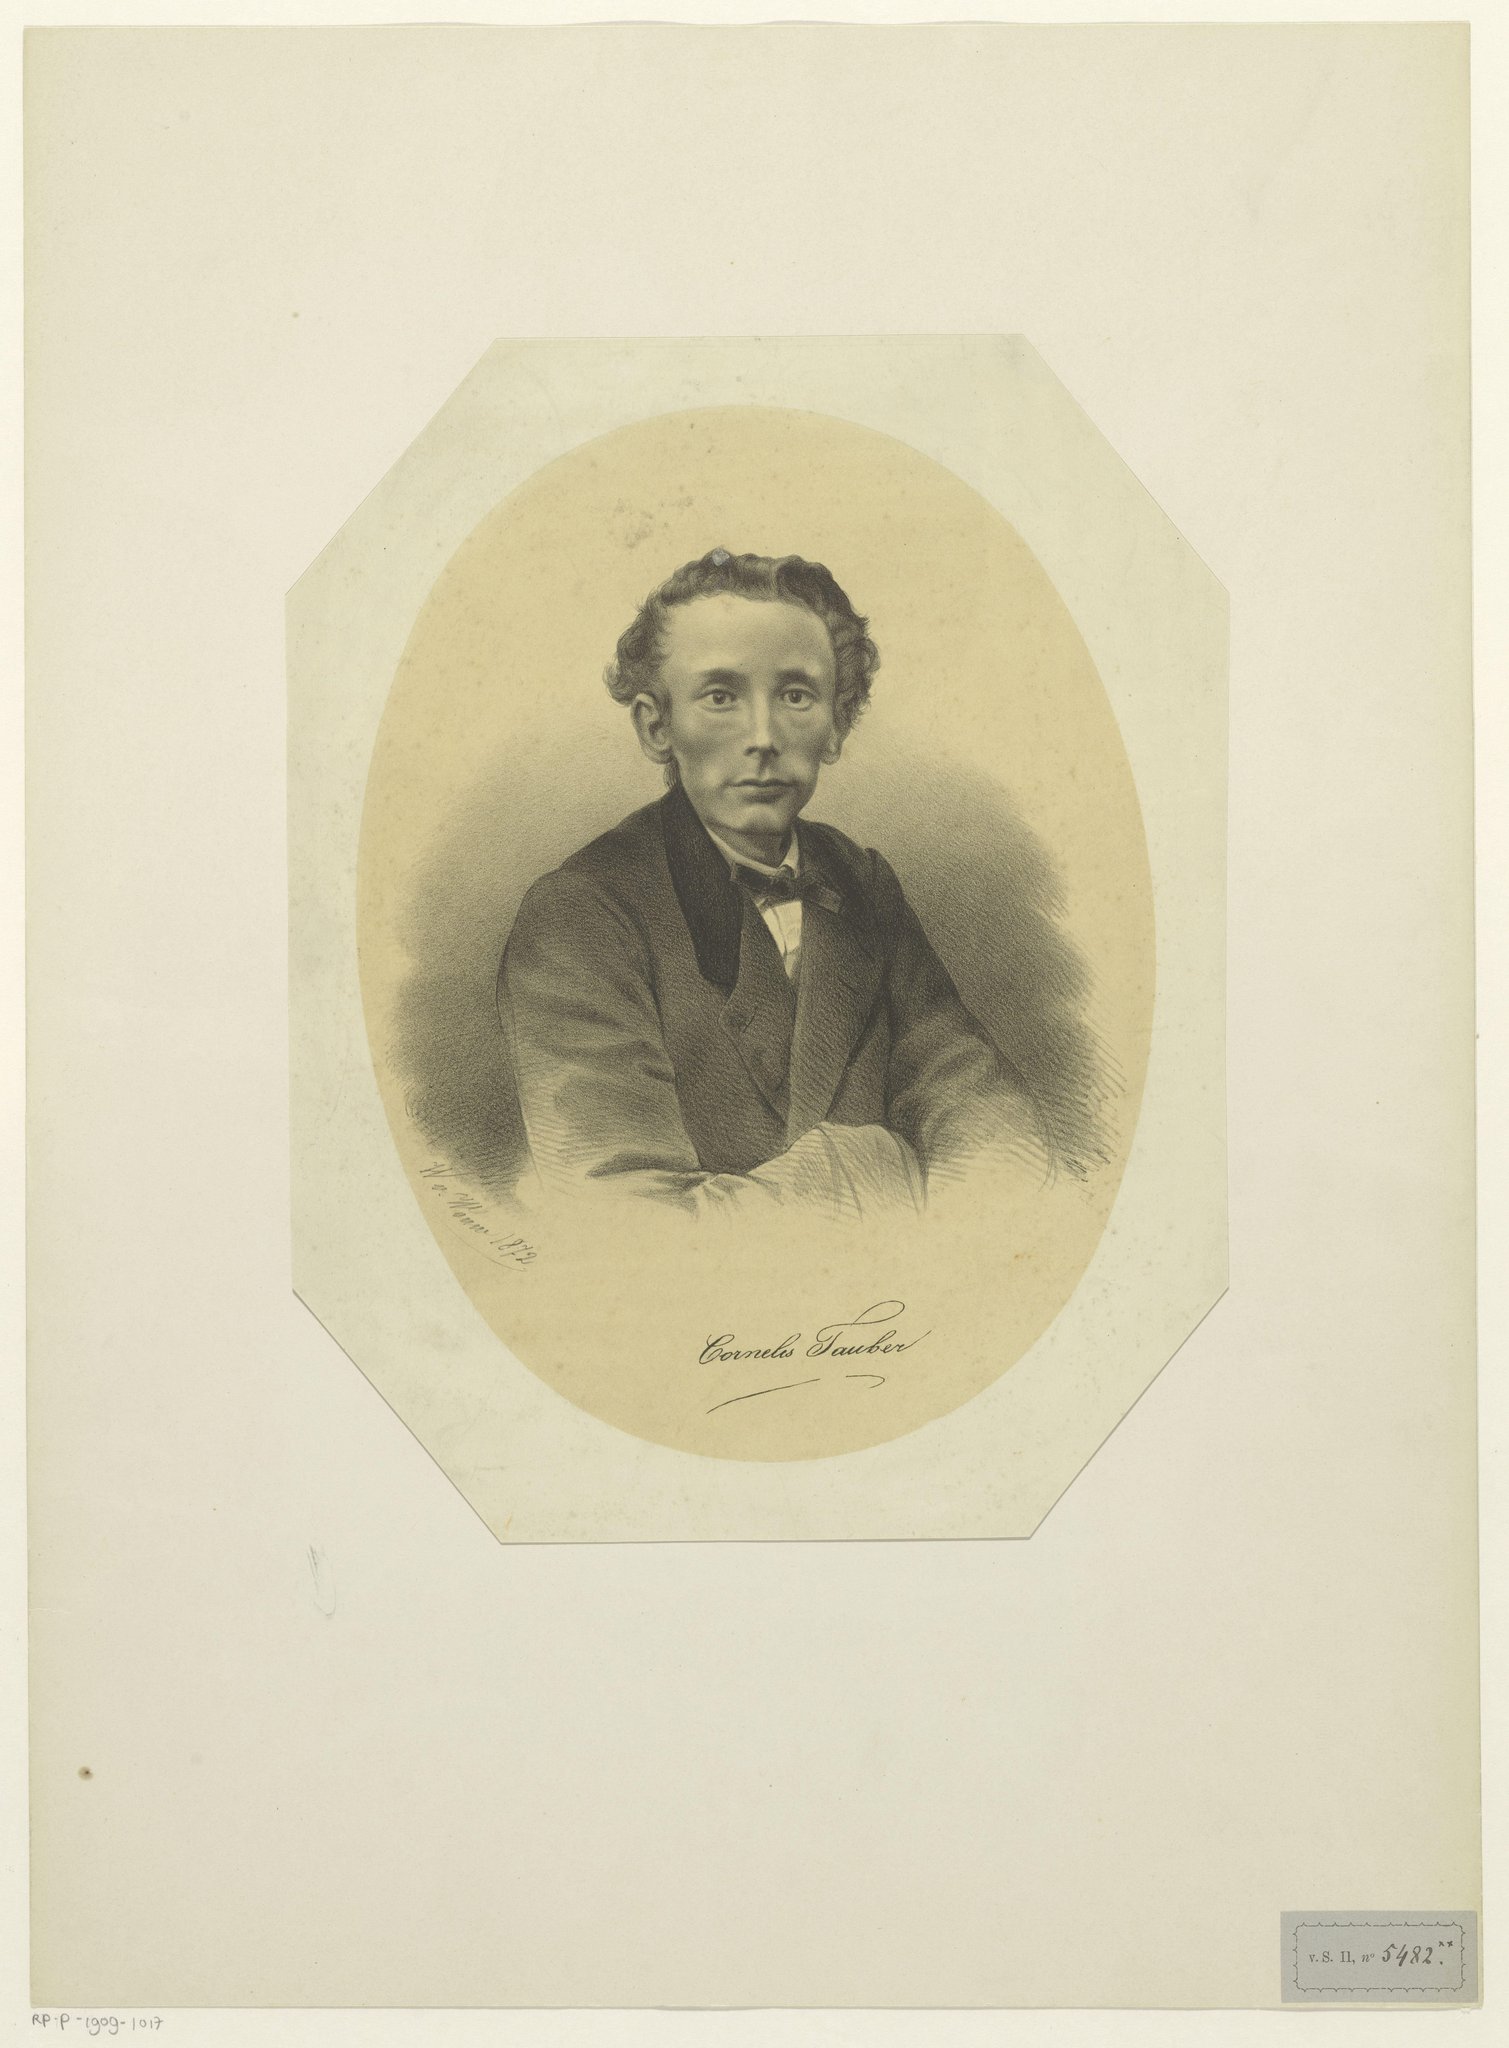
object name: print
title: Portret van Cornelis Tauber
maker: willem bastiaan van wouw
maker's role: print maker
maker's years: 1822-1878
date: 1872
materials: paper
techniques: tone lithography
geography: haarlem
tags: historical persons (+ half-length portrait)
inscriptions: collector's mark: Lugt 2228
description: Onder het portret de signatuur van de geportretteerde.